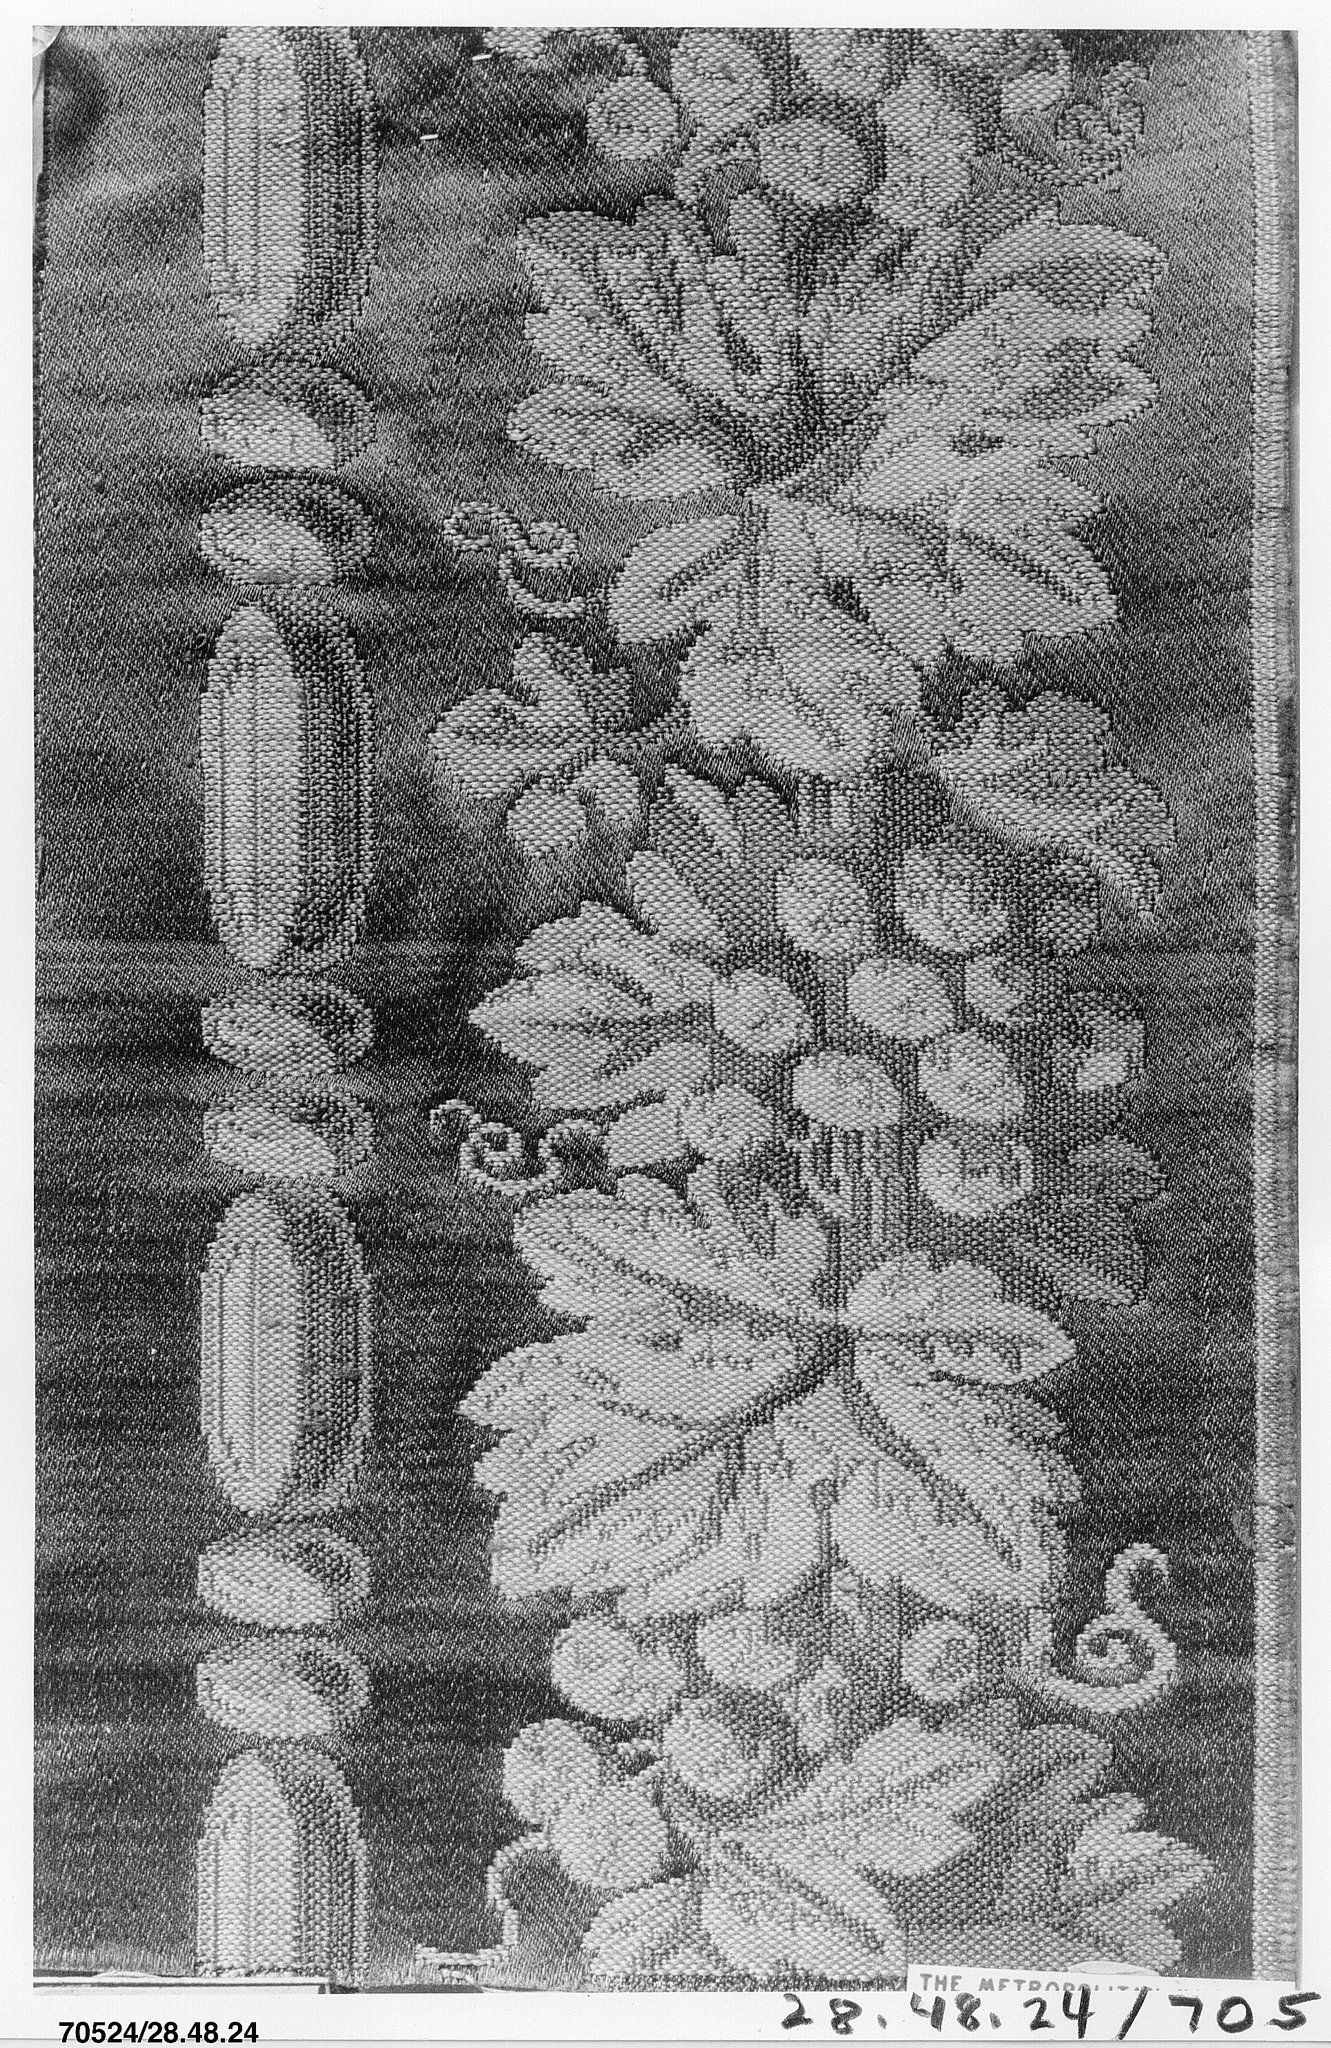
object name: piece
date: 1801-1900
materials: silk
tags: leaves